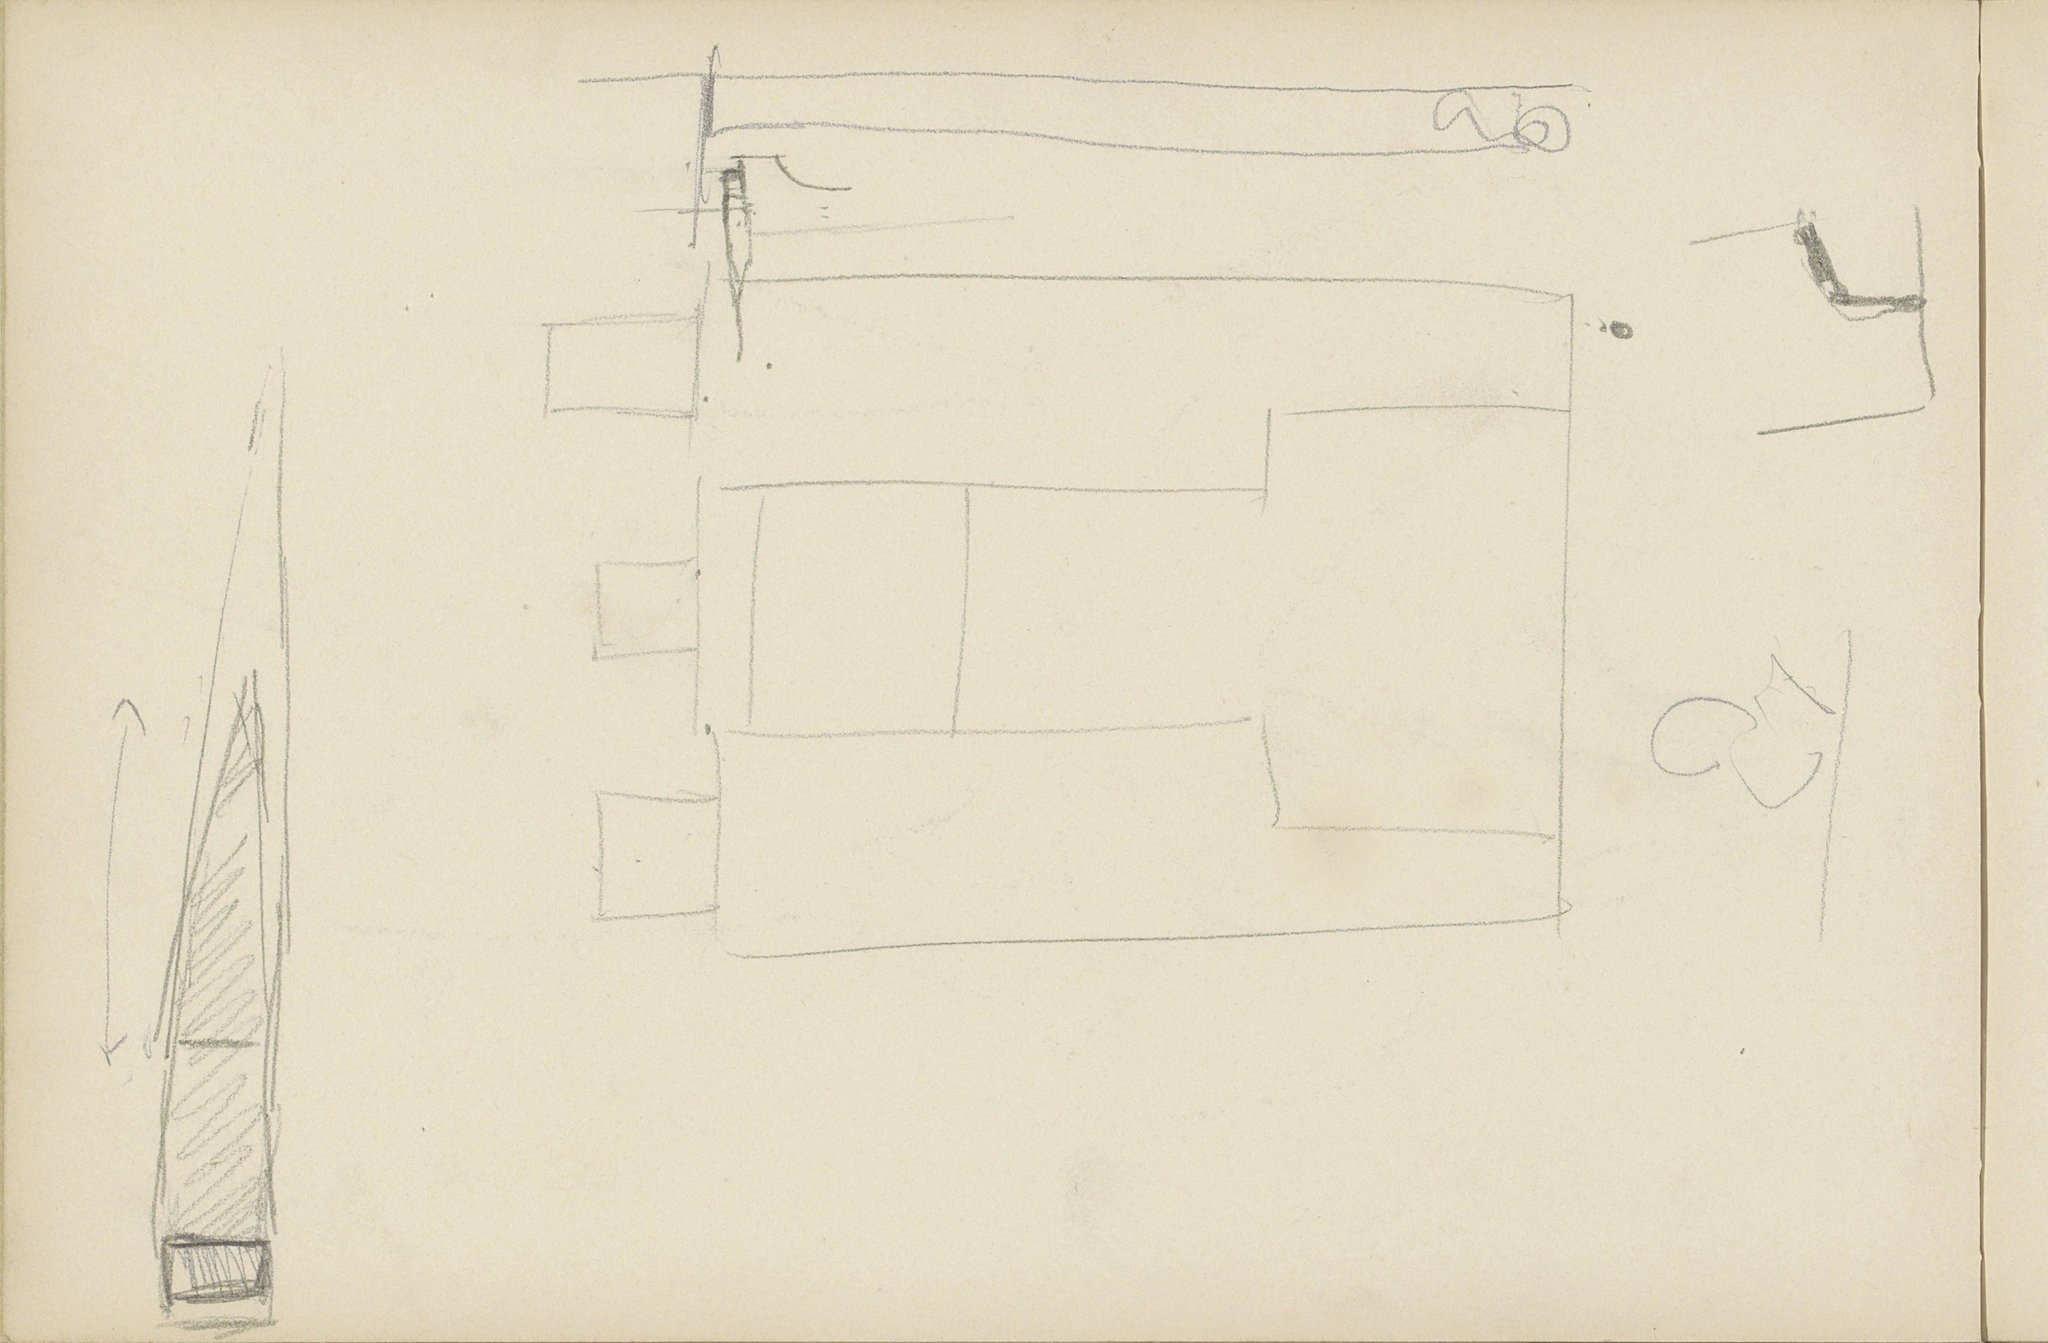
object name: sketchbook leaf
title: Studies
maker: carel adolph lion cachet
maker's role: draughtsman, print maker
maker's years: 1864-1945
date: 1908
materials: paper, pencil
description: Blad 14 verso uit een schetsboek met 25 bladen.